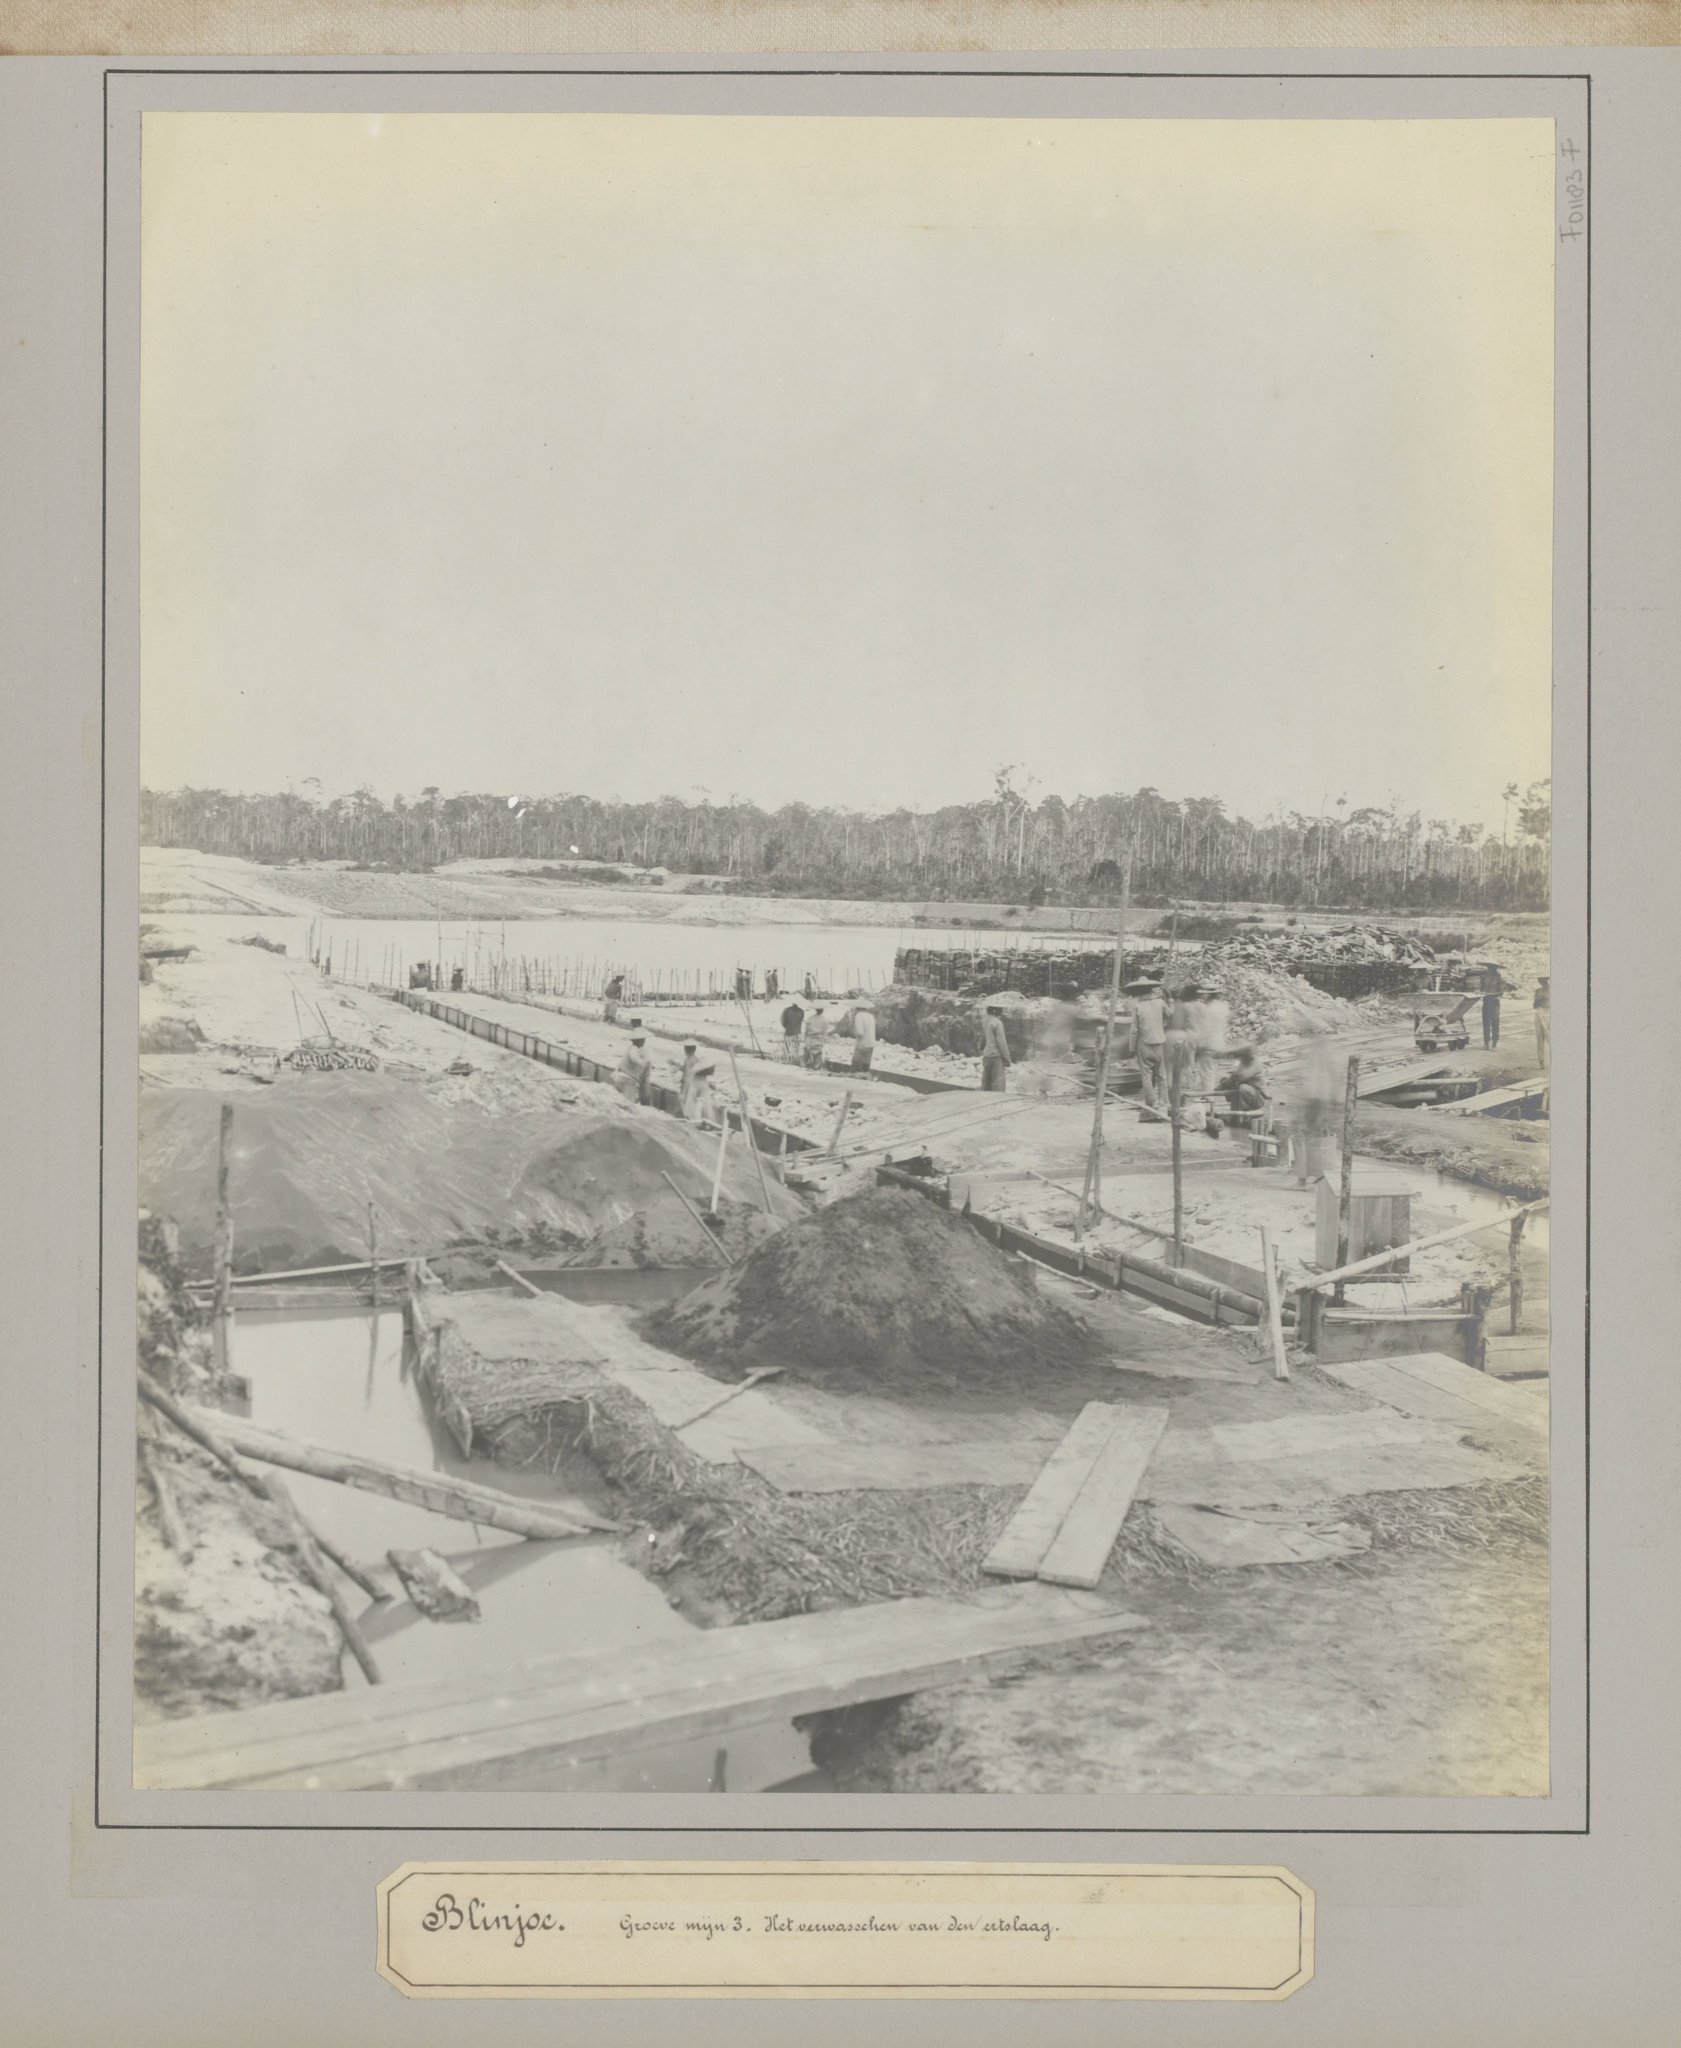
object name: photograph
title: Wasplaats voor tinerts te Belinyu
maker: Anonymous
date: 1900-1920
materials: photographic support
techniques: gelatin silver print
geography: belinyu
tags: mining, minerals and metals: tin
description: Onderdeel van Fotoalbum over de tinwinning op Bangka.